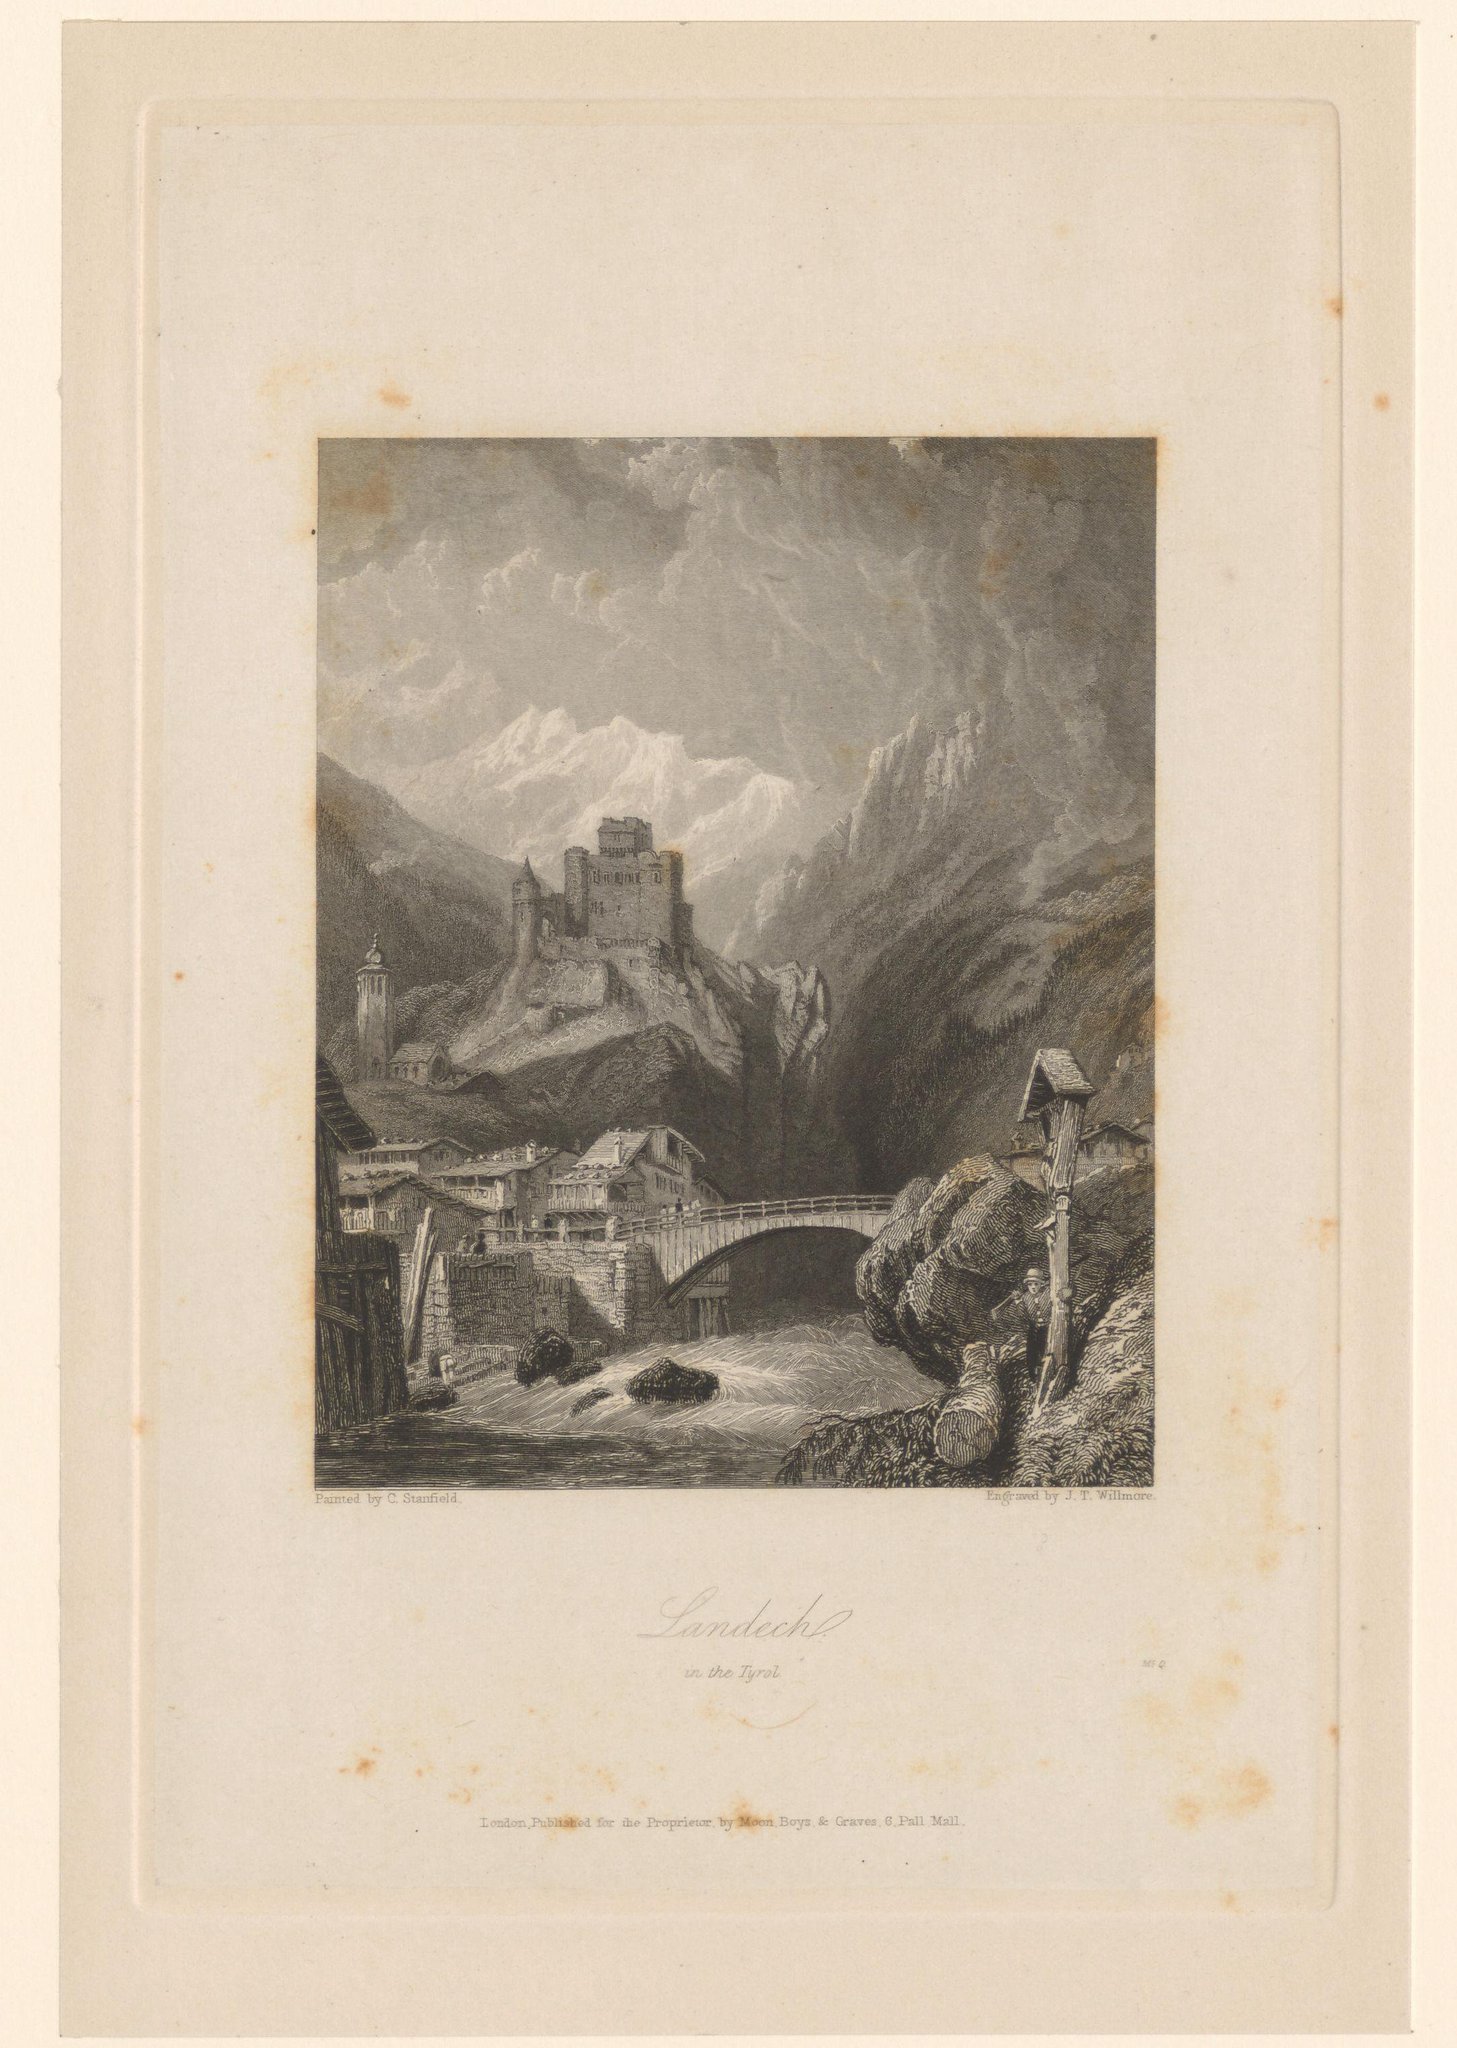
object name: print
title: Landech in the Tyrol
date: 1832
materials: paper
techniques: etching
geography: london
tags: city-view, and landscape with man-made constructions, river, landscape with tower or castle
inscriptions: collector's mark: Lugt 2228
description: Andere staat gebruikt in: Ritchie, Leitch. Heath's Picturesque Annual. Travelling Sketches in the North of Italy, the Tyrol, and on the Rhine. Londen: Longman, Rees, Orme, Brown & Green, 1832.